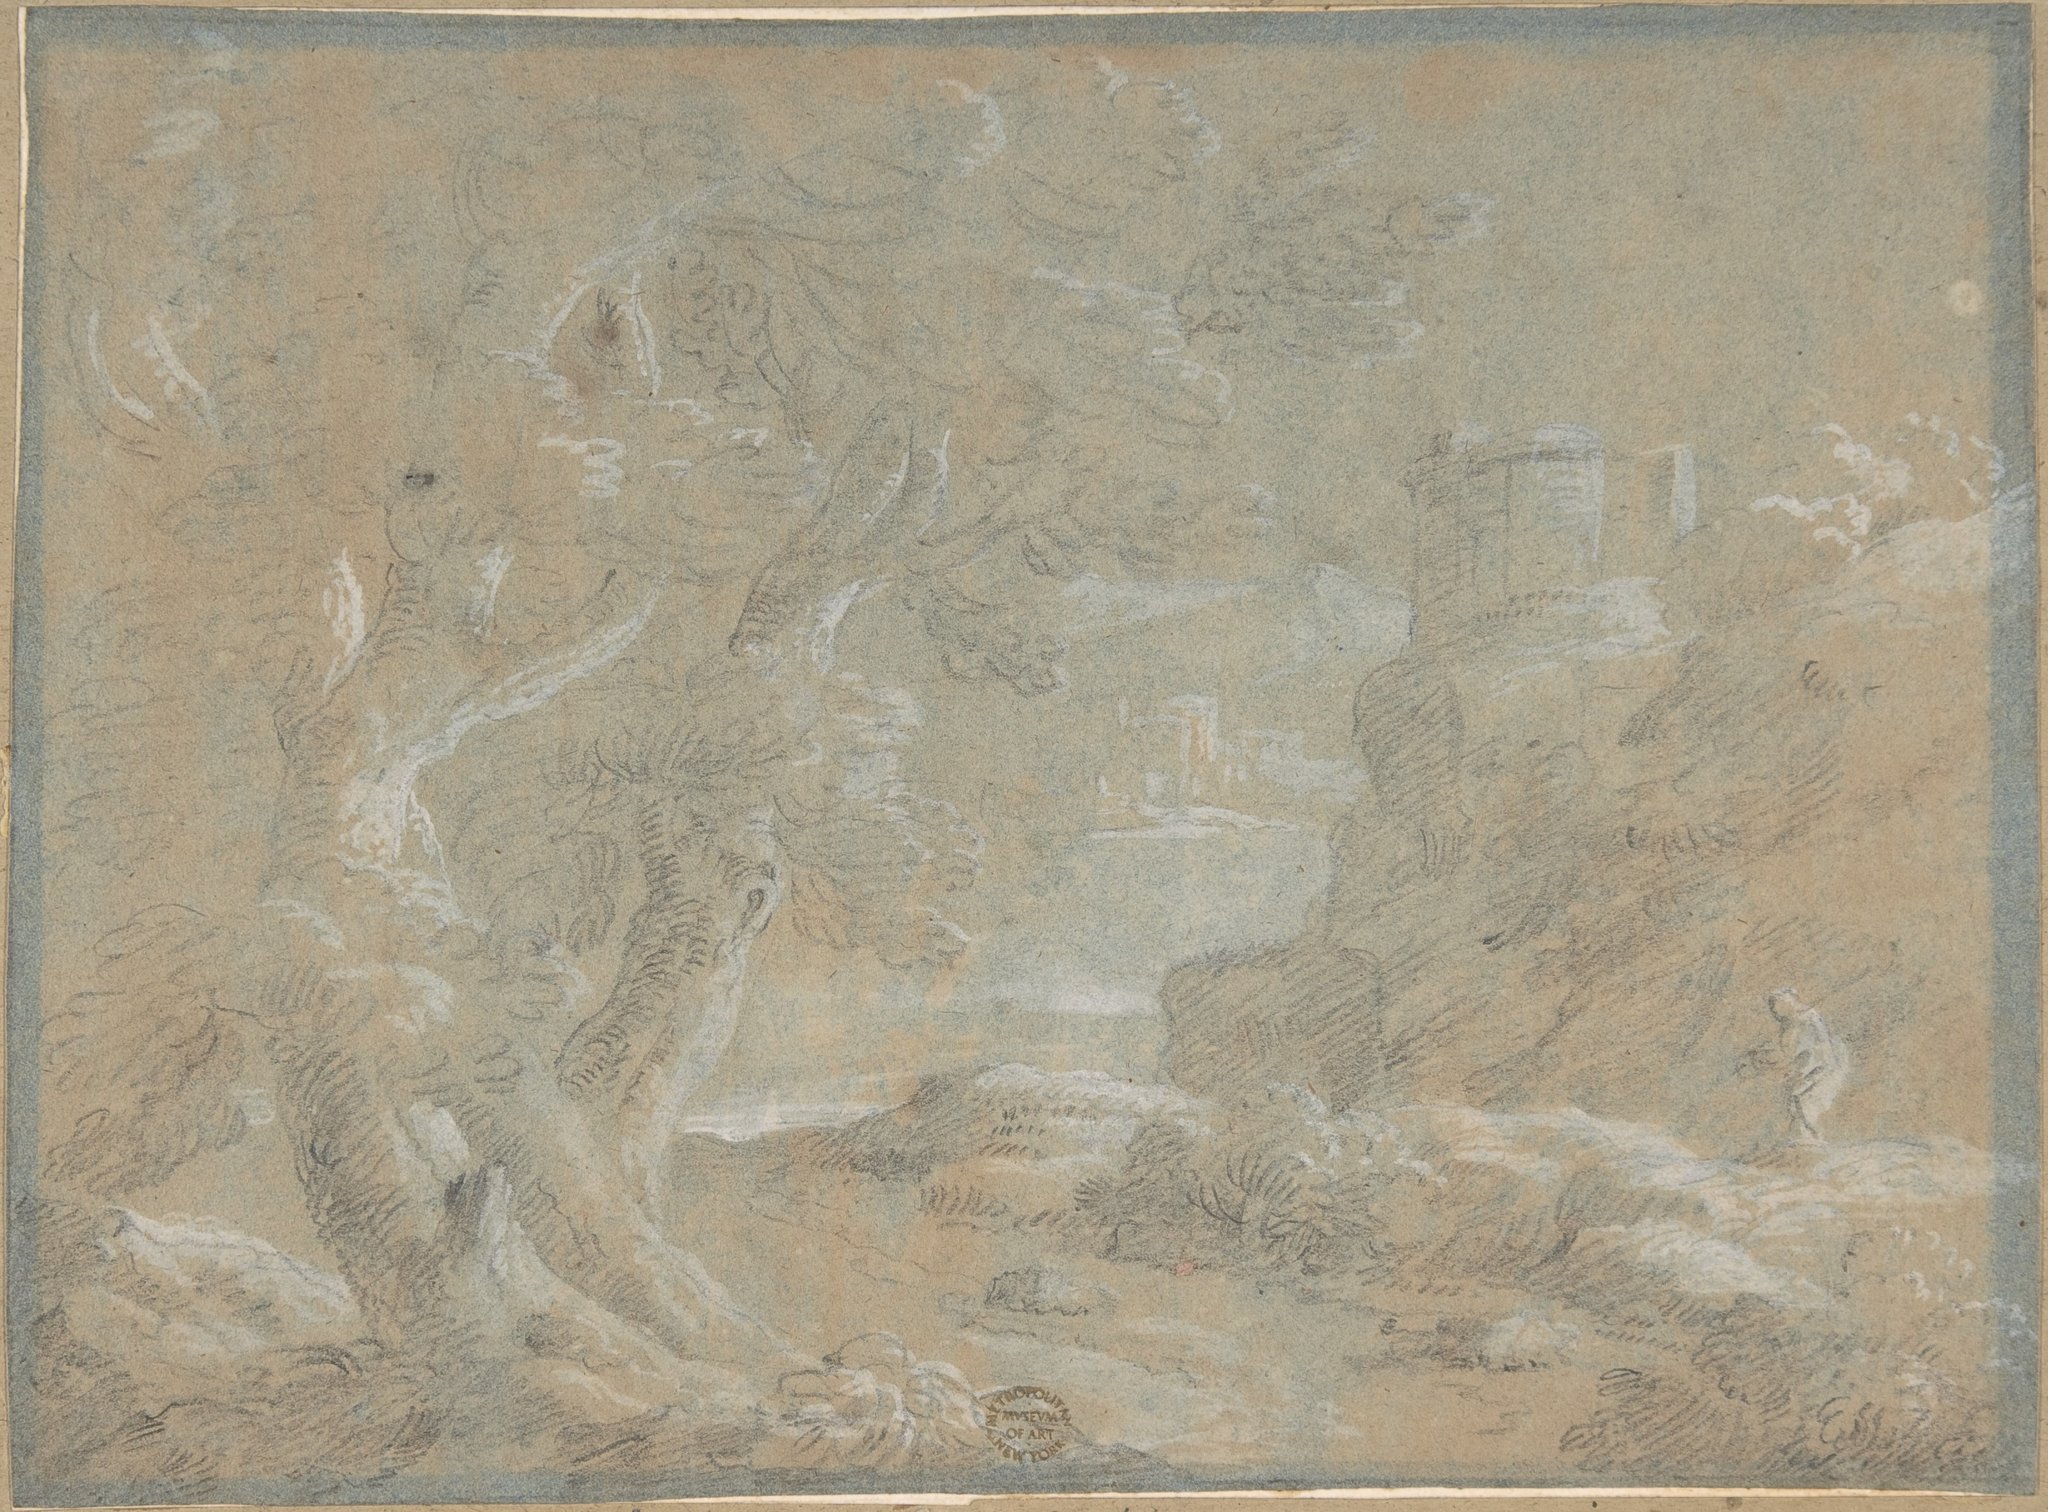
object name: drawing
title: Landscape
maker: anonymous, italian, roman-bolognese, 17th century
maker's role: artist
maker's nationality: italian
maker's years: 1600-1700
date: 1601-1700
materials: chalk, gouache, paper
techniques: highlighting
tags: landscapes,trees